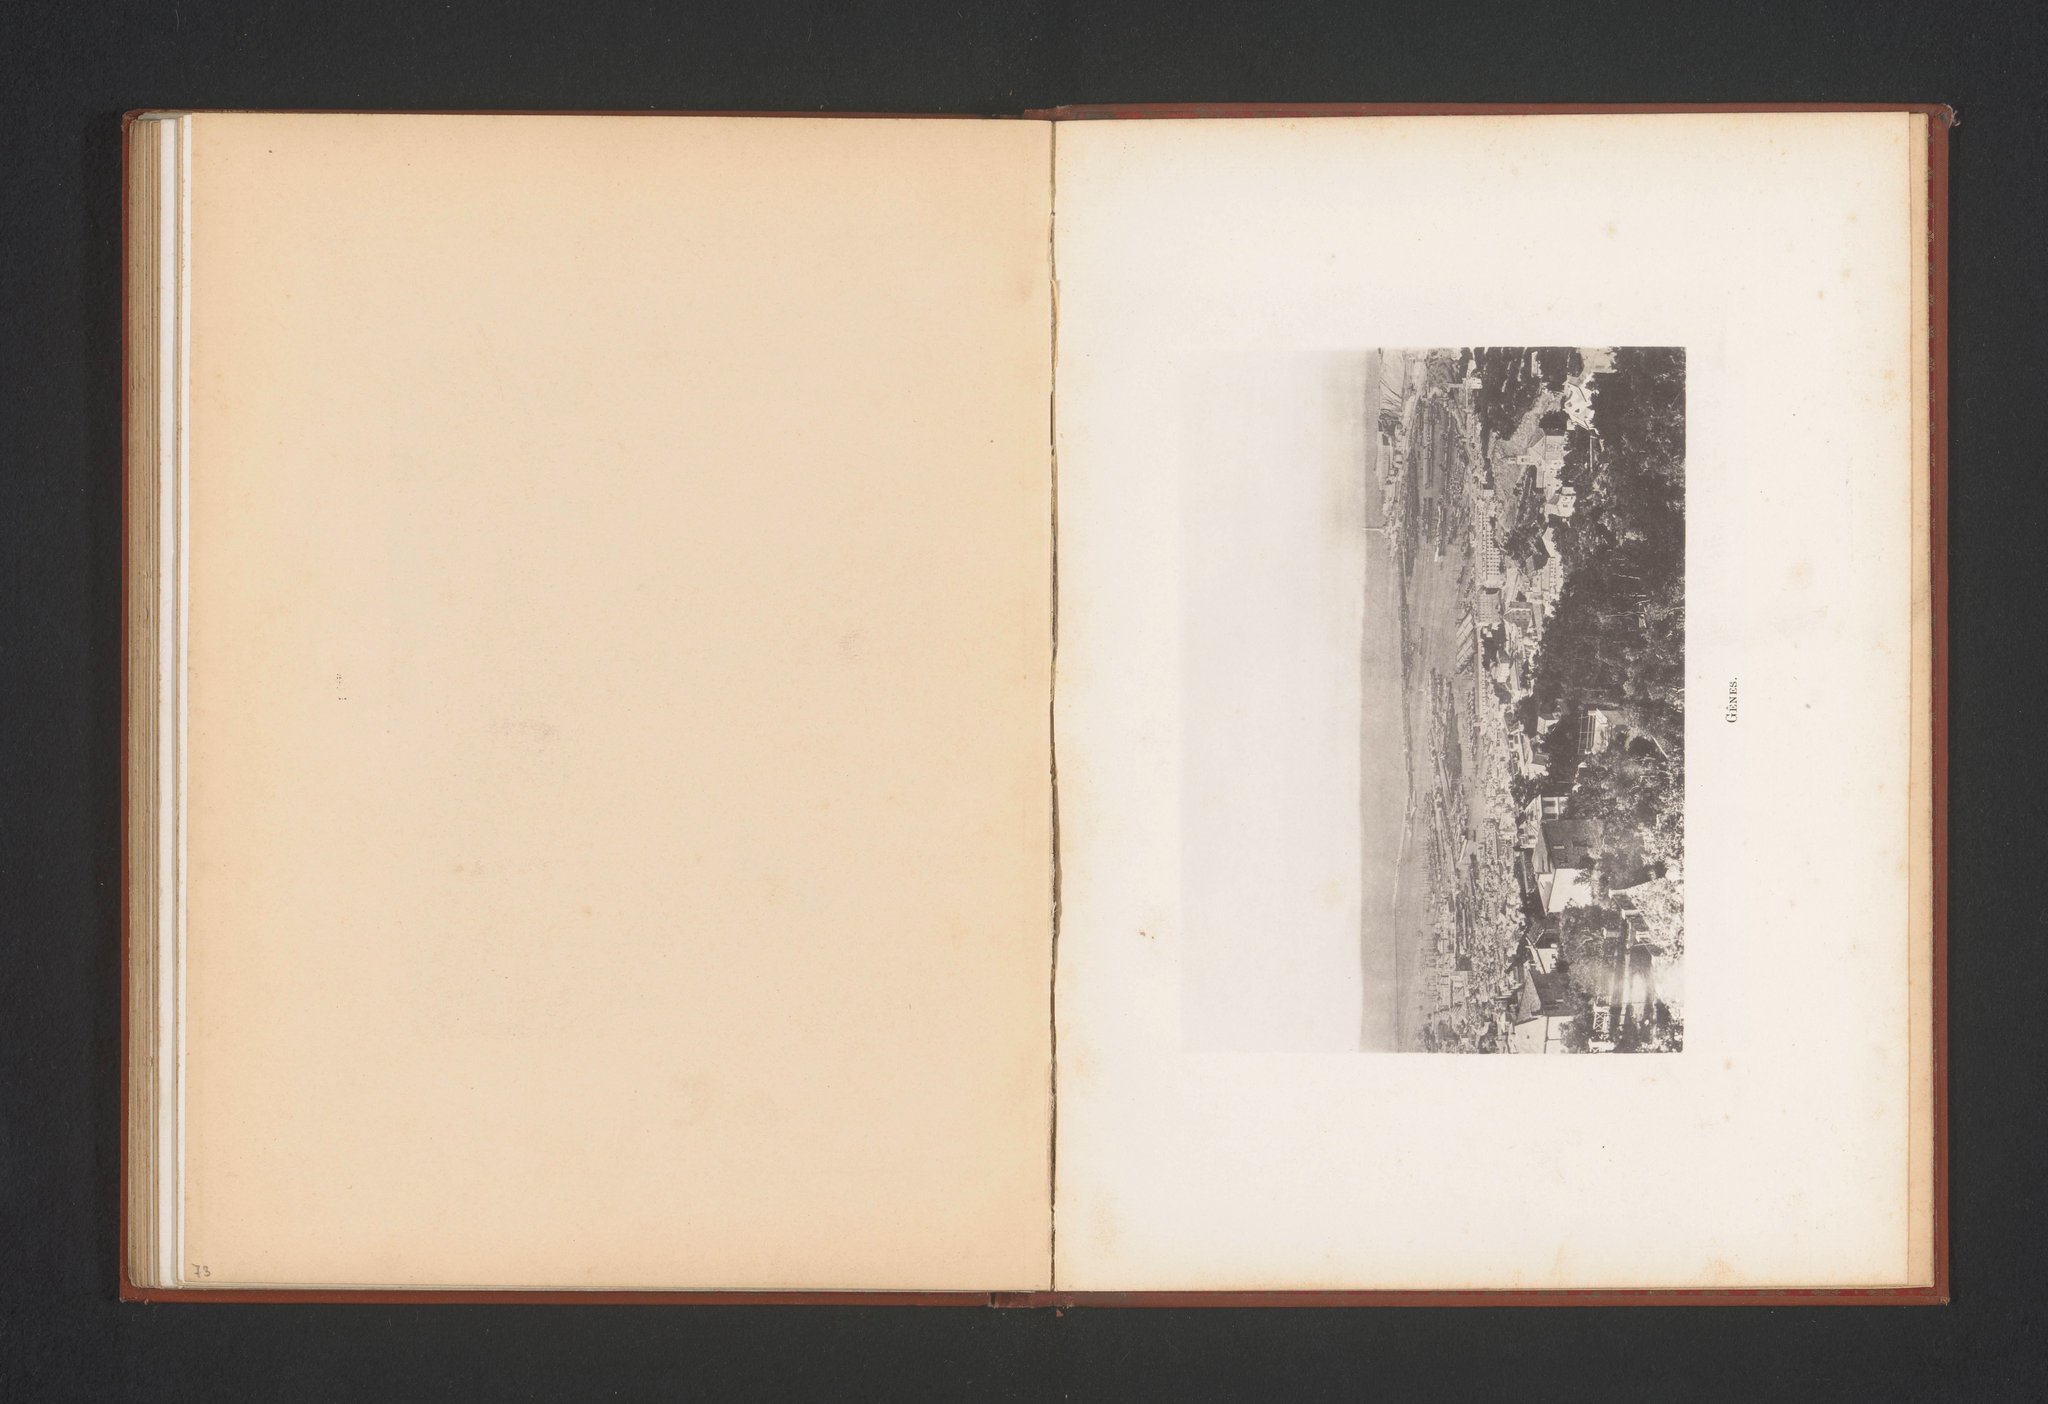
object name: photomechanical print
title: Gênes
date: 1890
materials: paper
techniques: photograph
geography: genoa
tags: city-view in general; 'veduta'